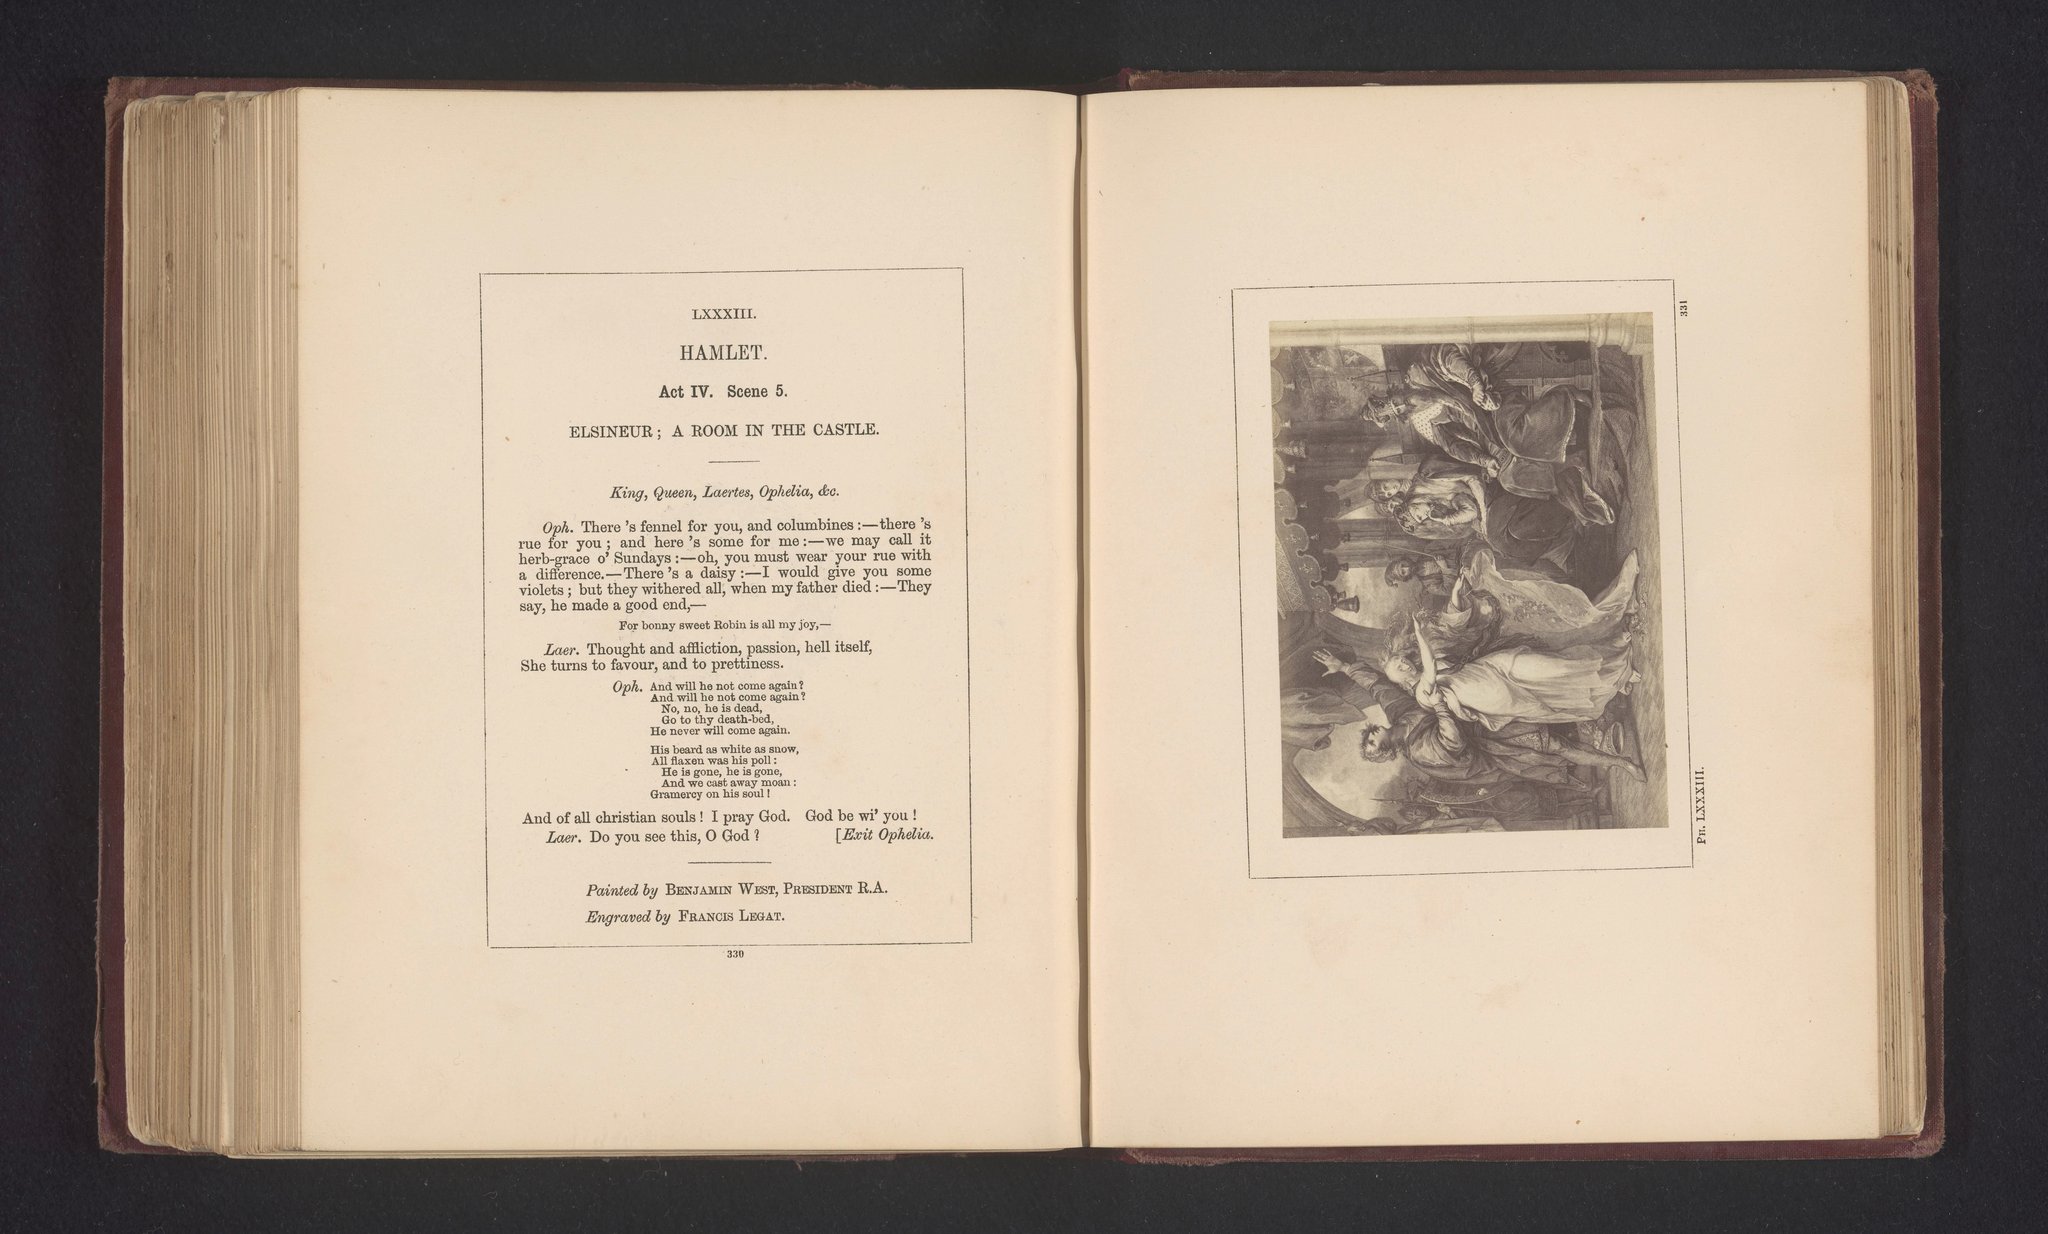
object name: photograph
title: Fotoreproductie van een prent naar een schilderij door Benjamin West, voorstellend een scene uit Hamlet door William Shakespeare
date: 1854-1867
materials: photographic support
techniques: albumen print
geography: london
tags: ophelia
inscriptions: number: ‘Ph. LXXXIII. 331’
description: Te zien is akte IV, scene 5 met Ophelia en Laertes voor de koning en de koningin.